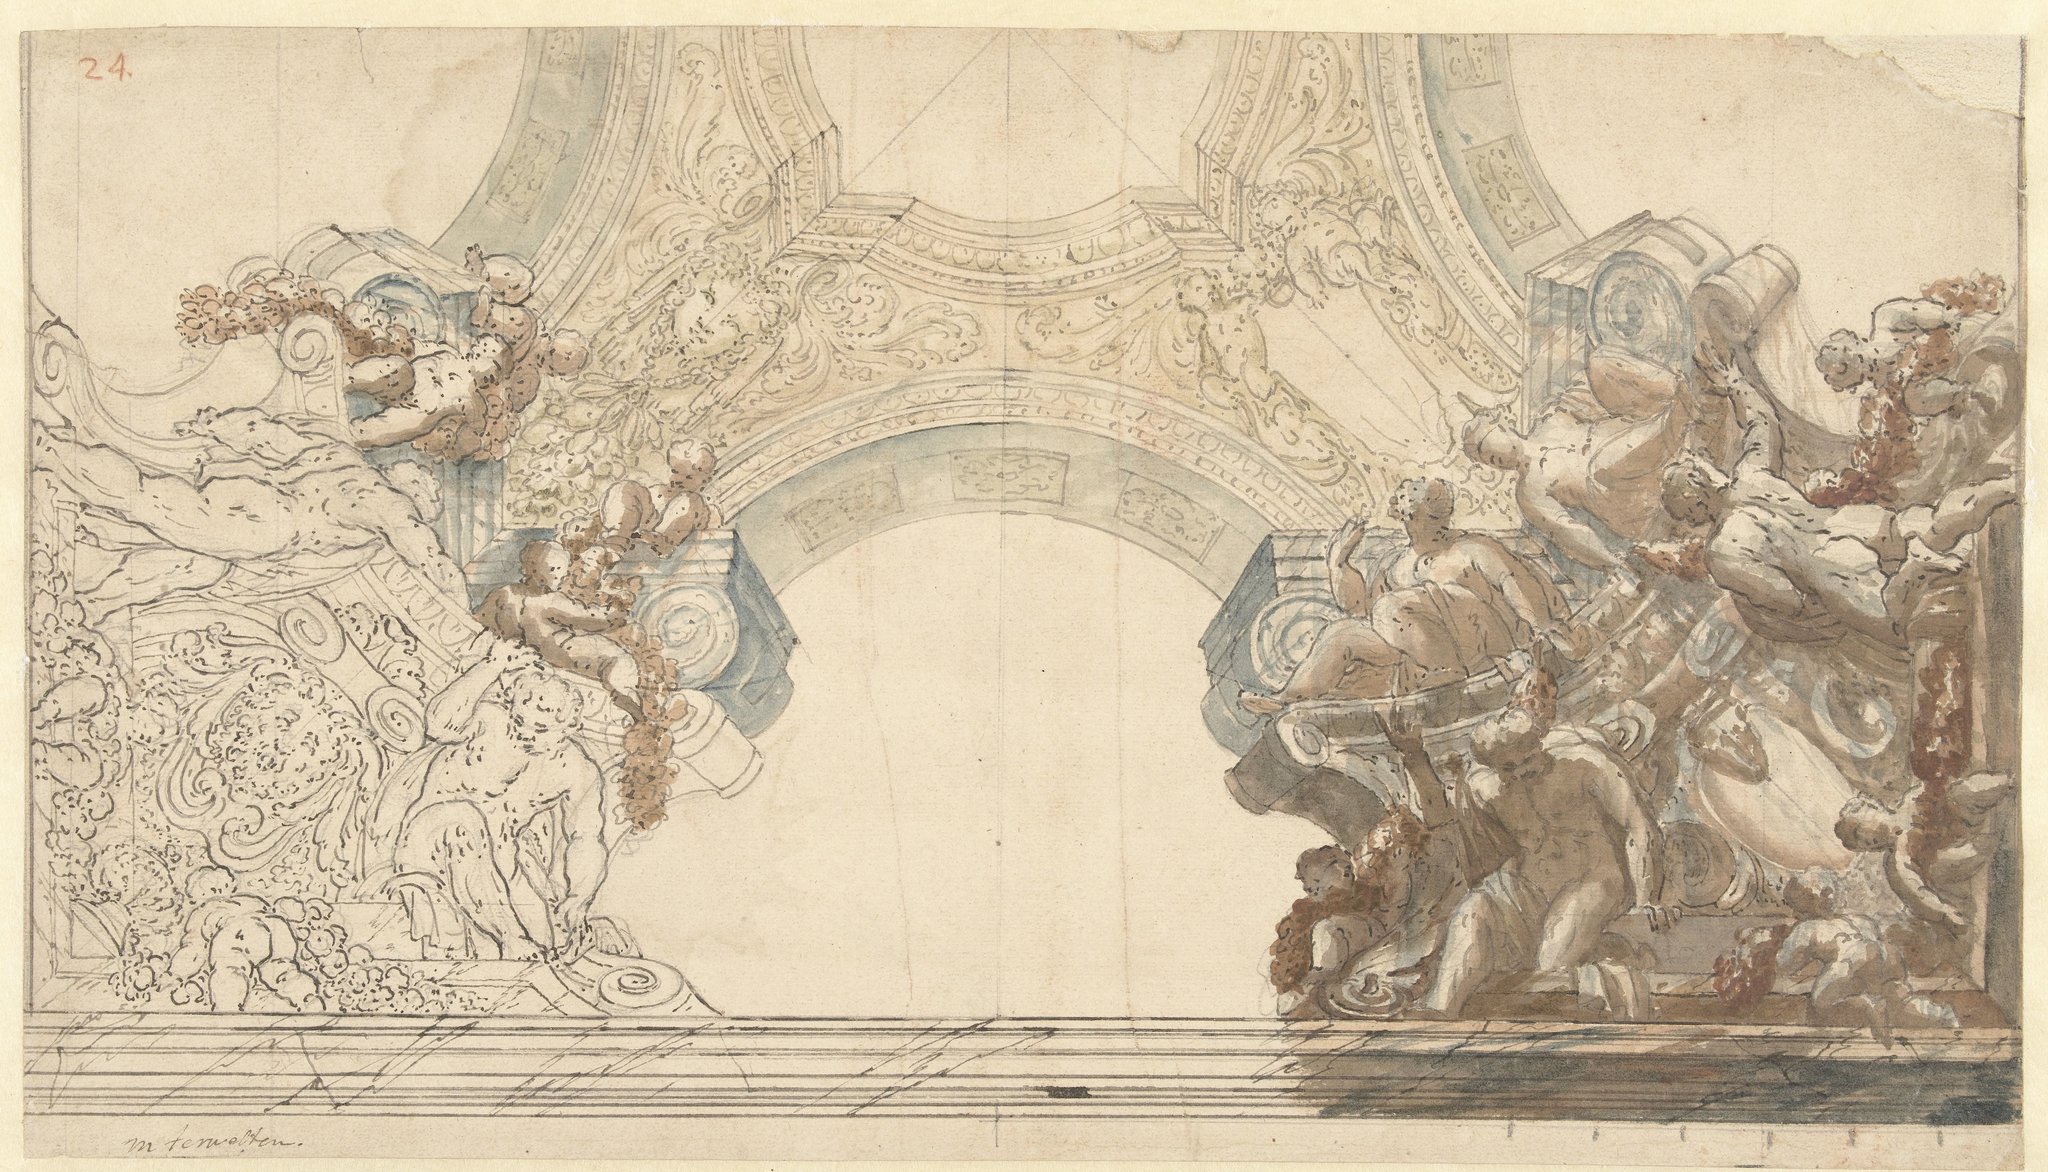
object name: design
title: Ontwerp voor een plafond met Michelangeleske figuren en ornament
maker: mattheus terwesten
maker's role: draughtsman, painter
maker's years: 1670-1757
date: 1680-1757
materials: graphite, ink, paper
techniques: brush, pen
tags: (decorated) ceiling